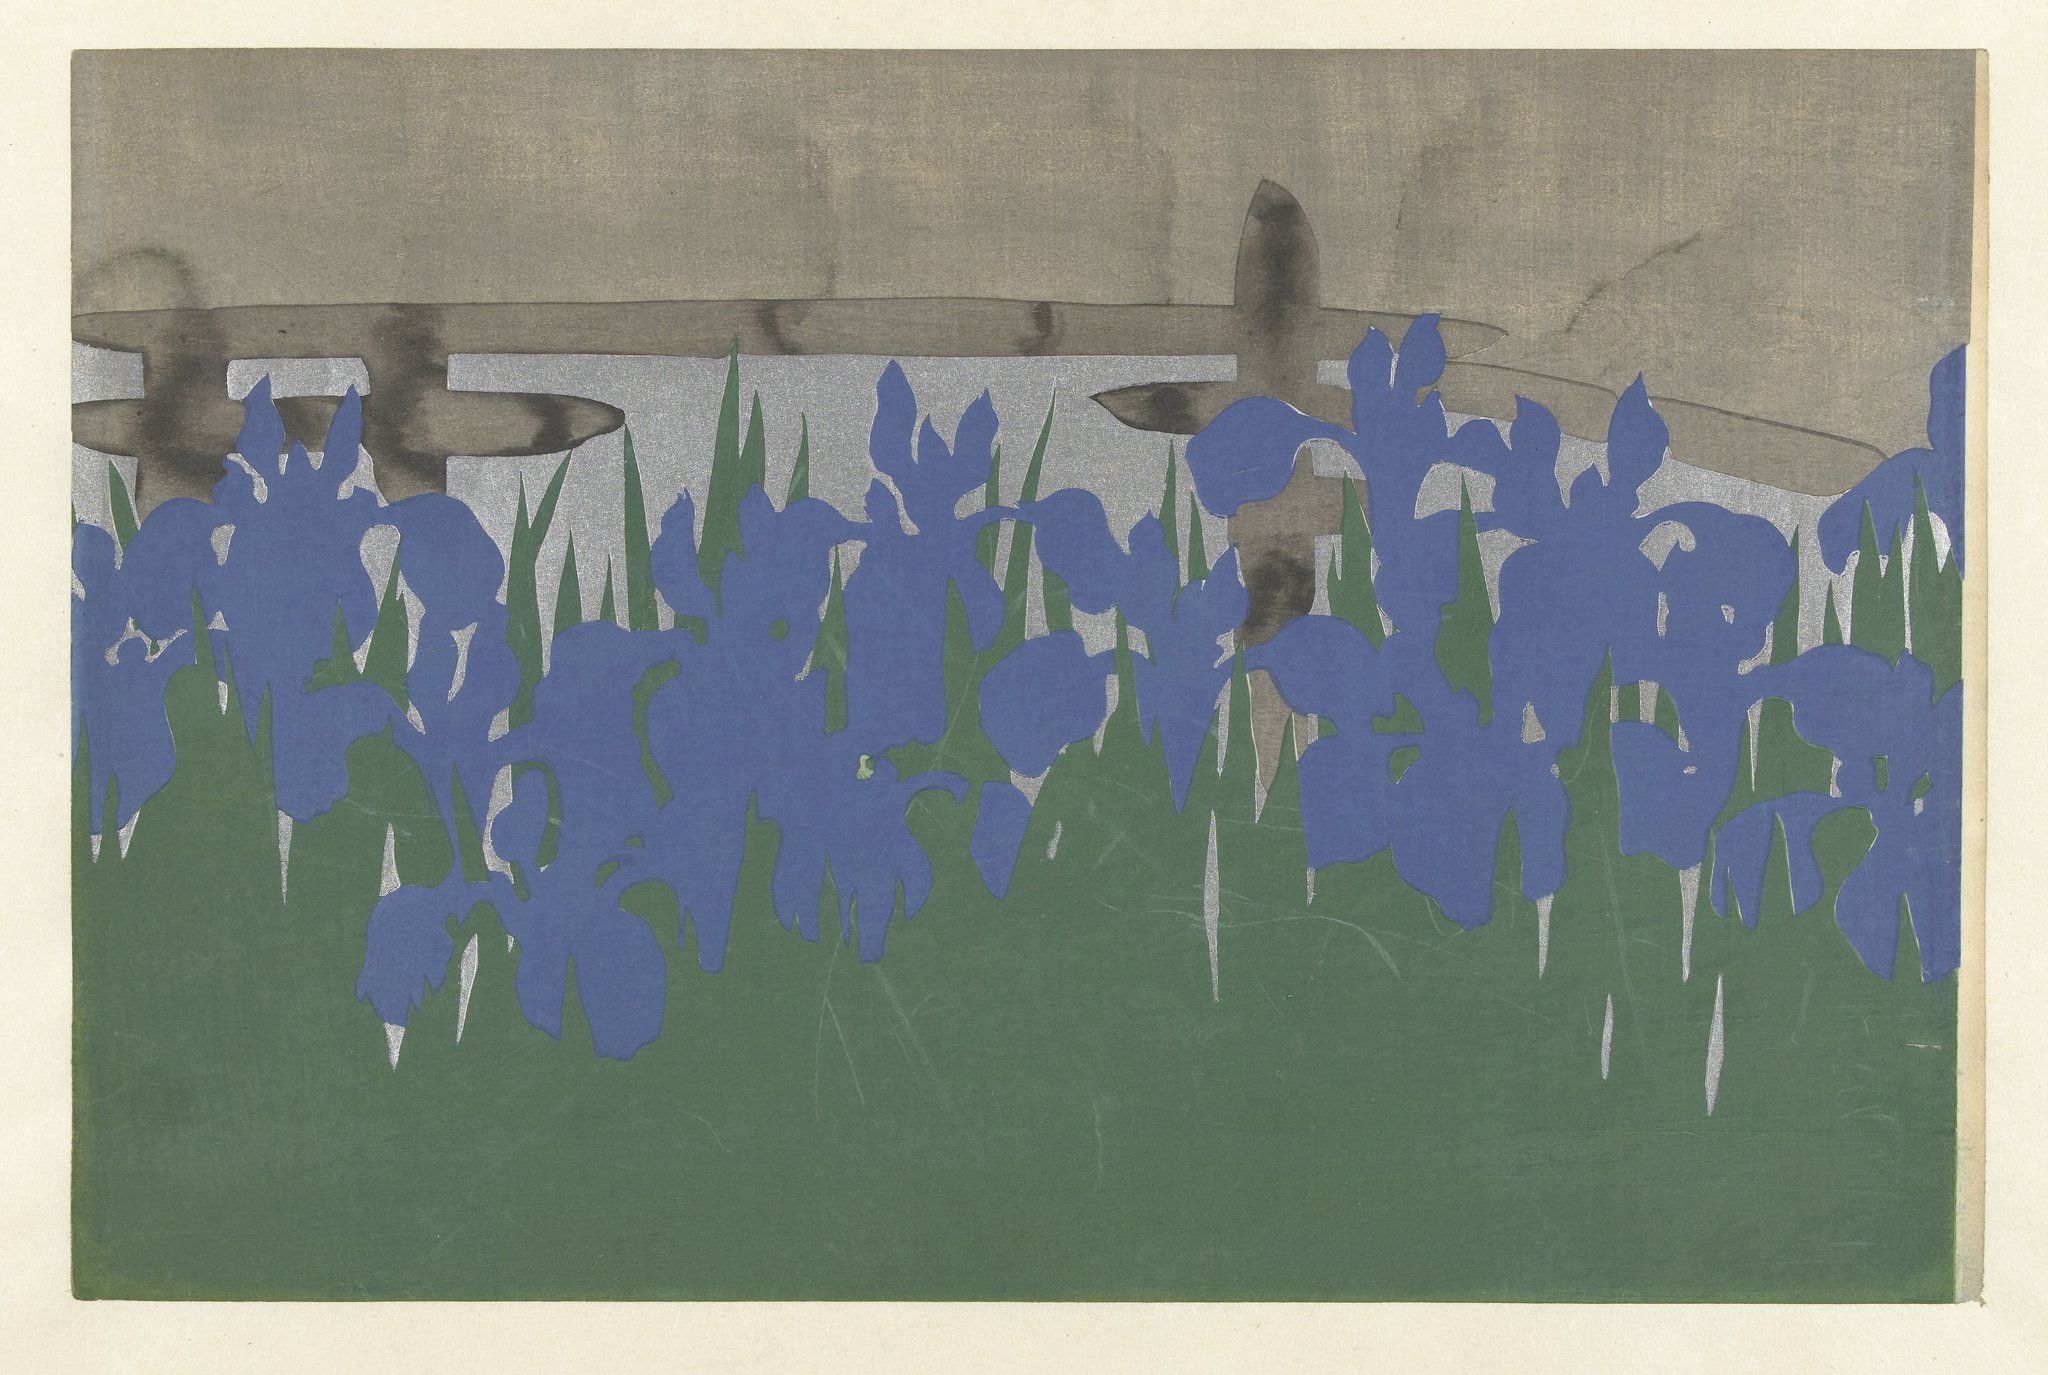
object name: print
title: Yatsubashi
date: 1909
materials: paper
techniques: woodcut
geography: kyoto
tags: flowers: iris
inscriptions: collector's mark: Lugt 2760, collector's mark: Lugt 2228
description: Japanse titel volgens inhoudsopgave. Yatsubashi (letterlijk acht bruggen) was beroemd vanwege de irissen rondom de houten bruggen.